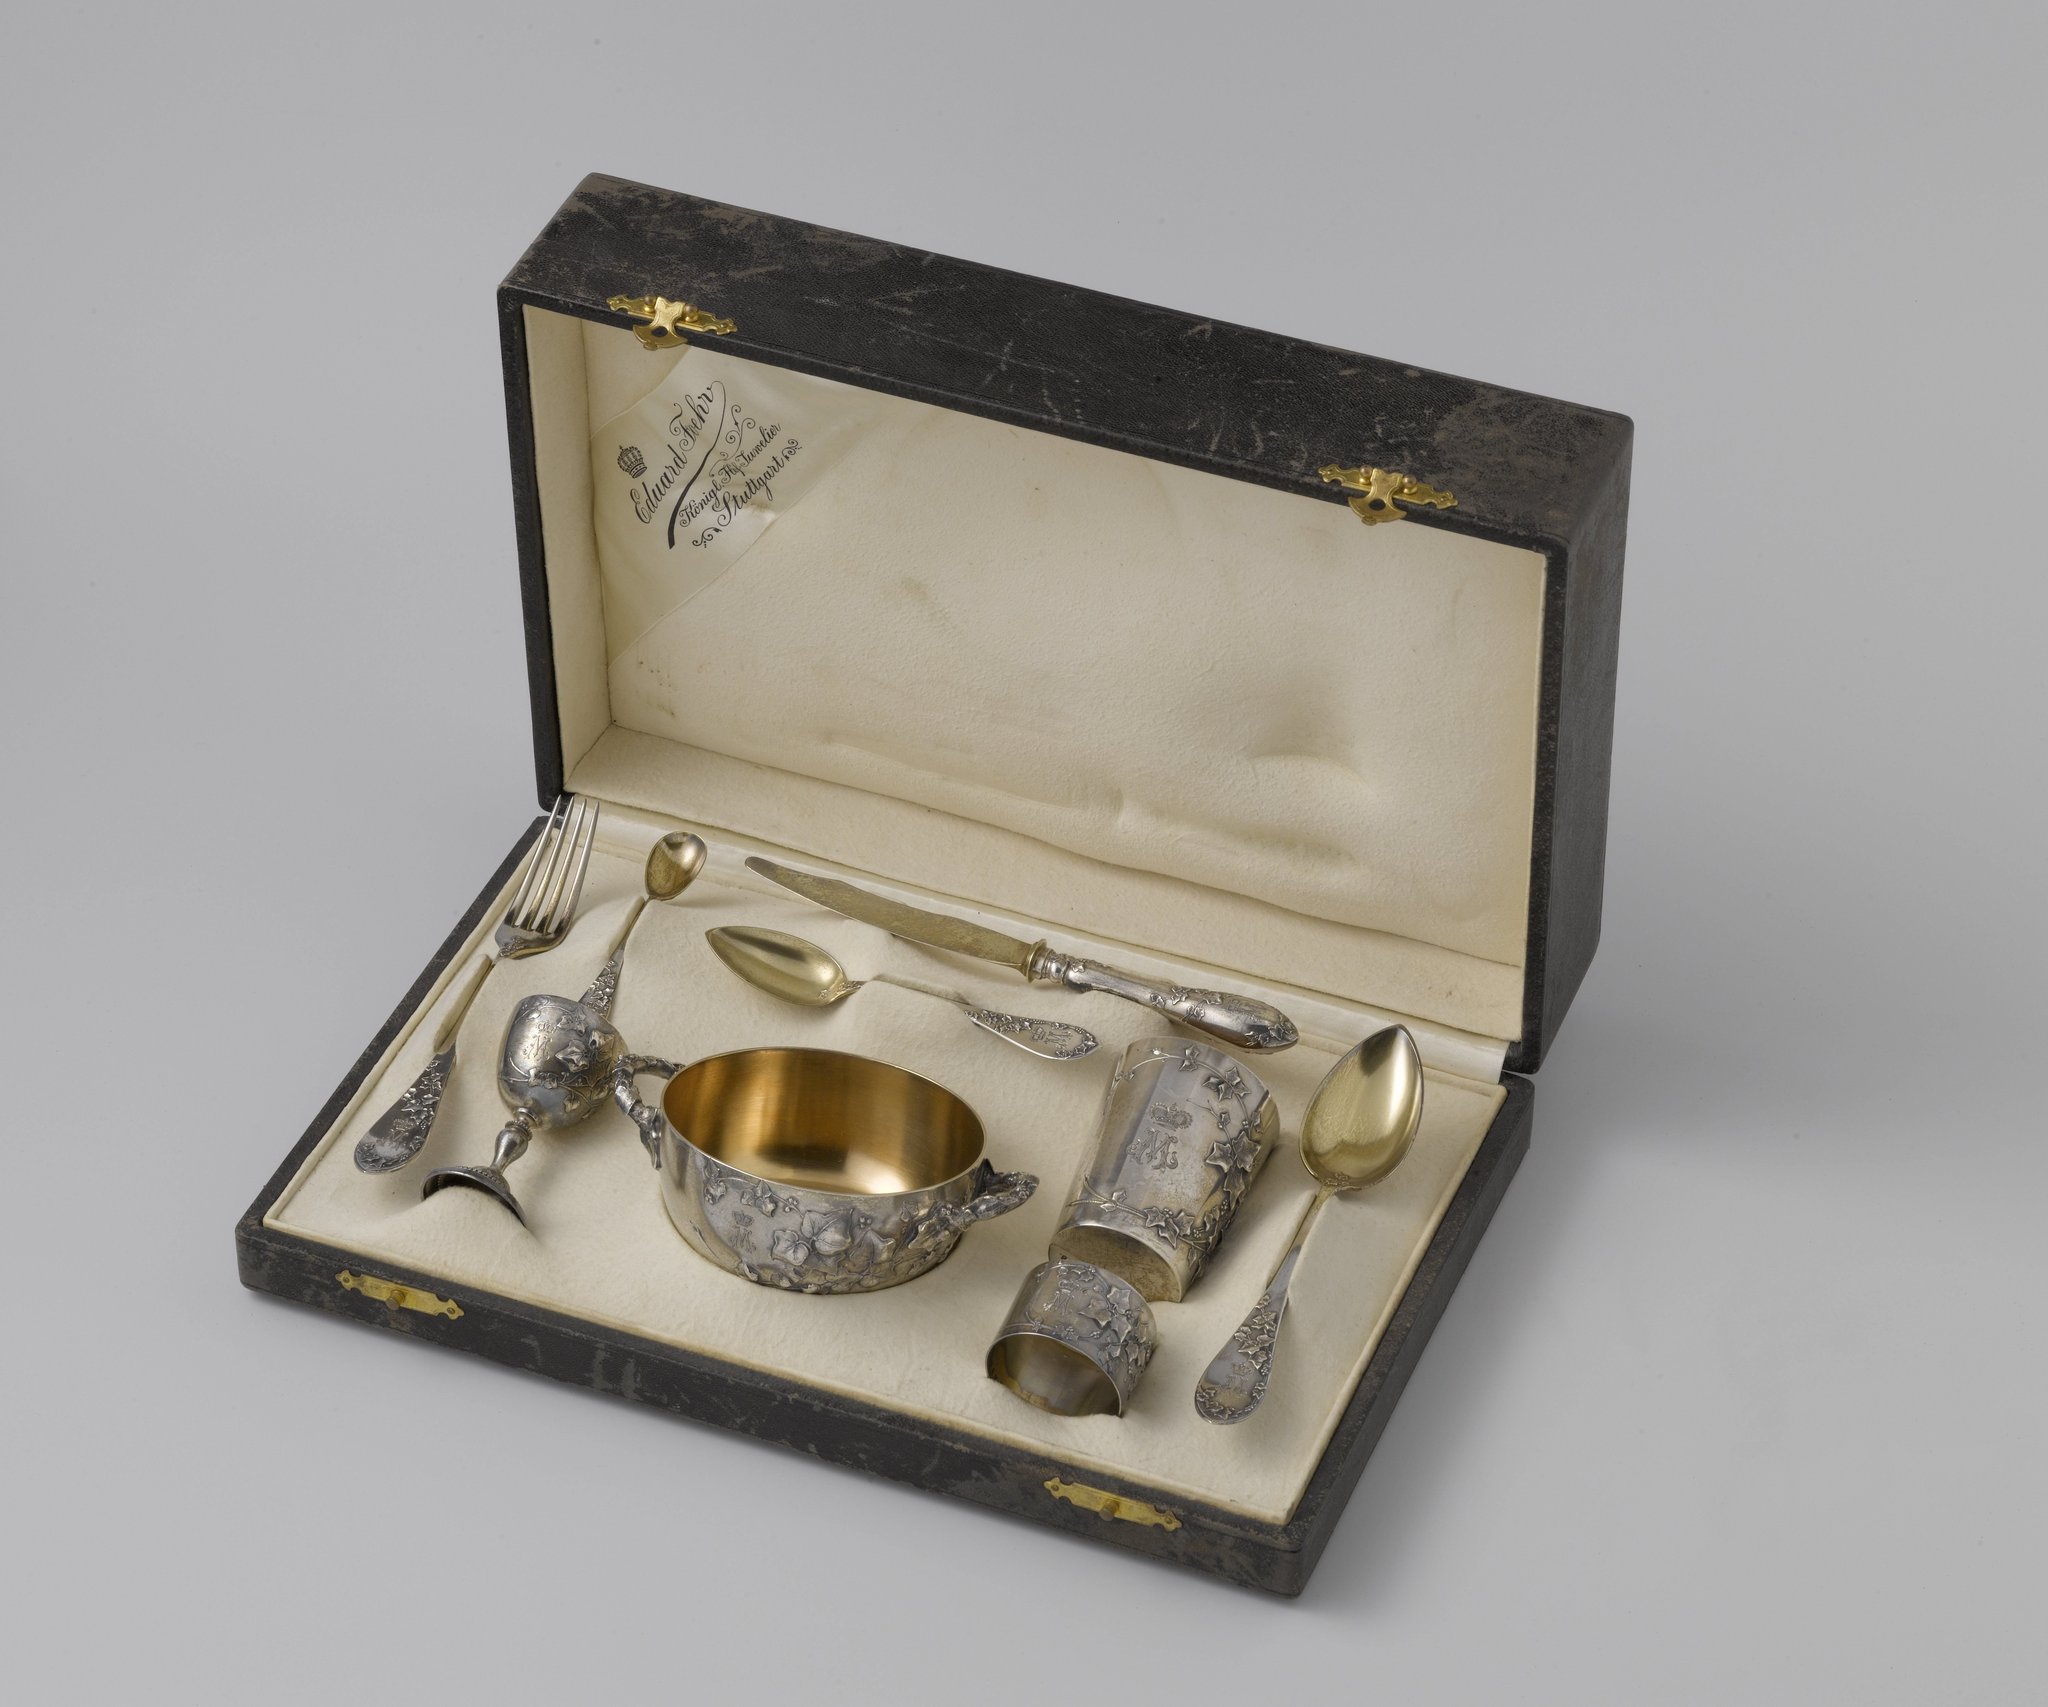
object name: kinderservies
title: Kinderservies van zilver, gedeeltelijk verguld, met bijbehorend bestek, tezamen in een cassette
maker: peter bruckmann en söhne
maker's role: zilverfabrikant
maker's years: 1778-1850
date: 1900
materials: silver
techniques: gilding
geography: germany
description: Kinderservies van zilver, gedeeltelijk verguld. Bestaande uit een papkom, kroesje, eierdopje, servetring, vork, lepel, dessertlepel, theelepel en een mes in een cassette.